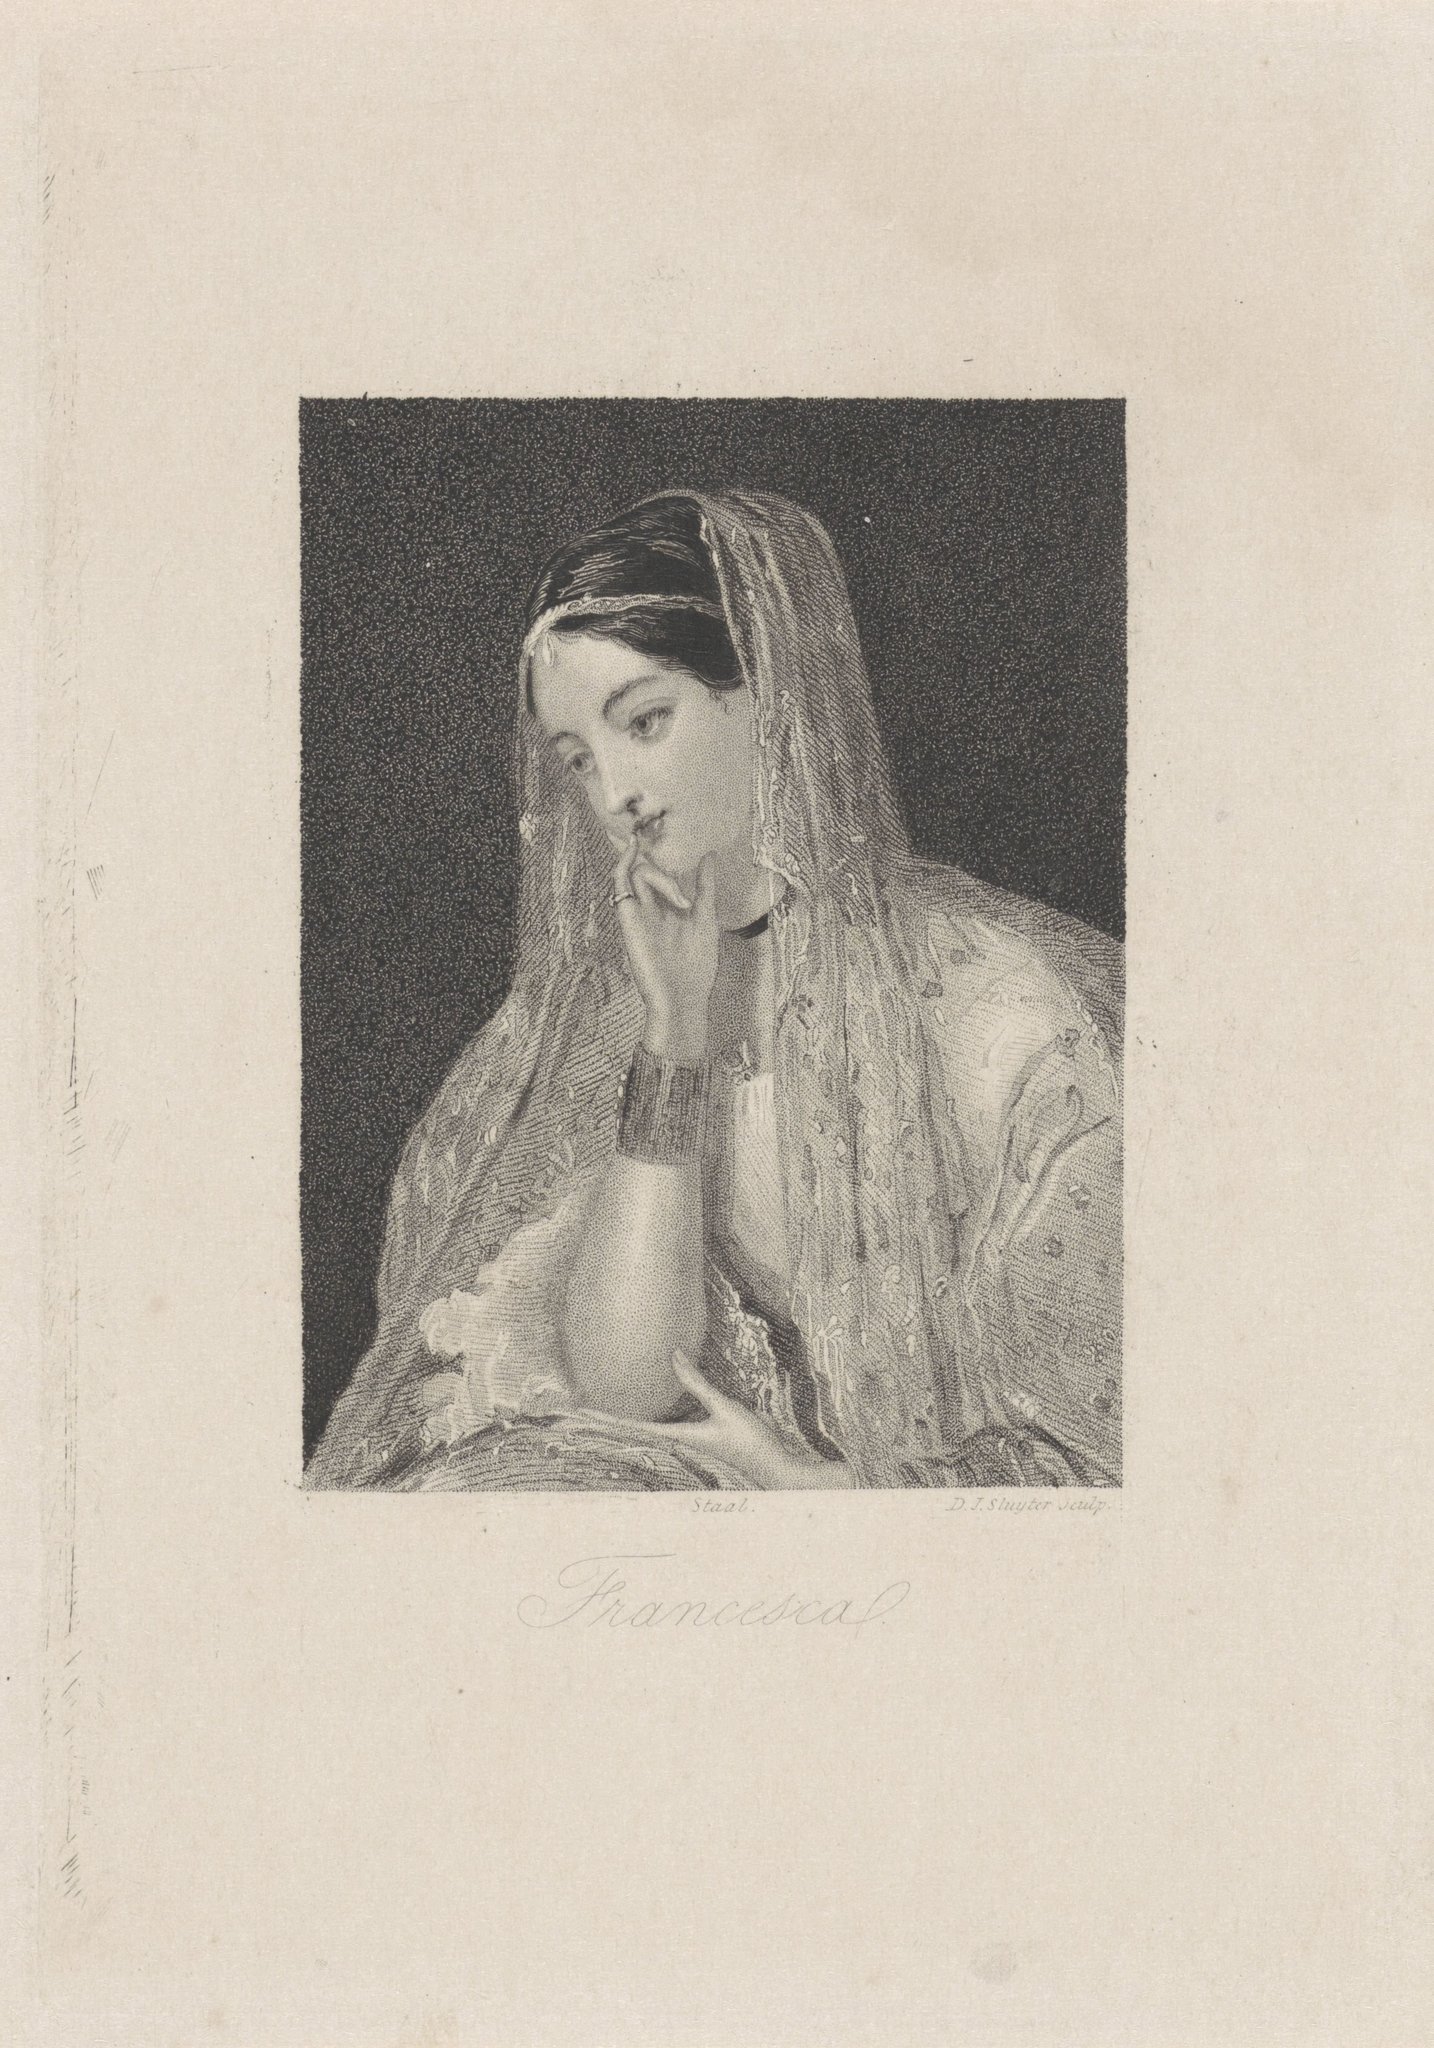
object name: print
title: Francesca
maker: dirk jurriaan sluyter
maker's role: draughtsman, print maker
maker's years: 1811-1886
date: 1826-1886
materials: paper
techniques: steel etching, stippling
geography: amsterdam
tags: veil (+ lace used for clothes)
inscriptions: collector's mark: Lugt 2228